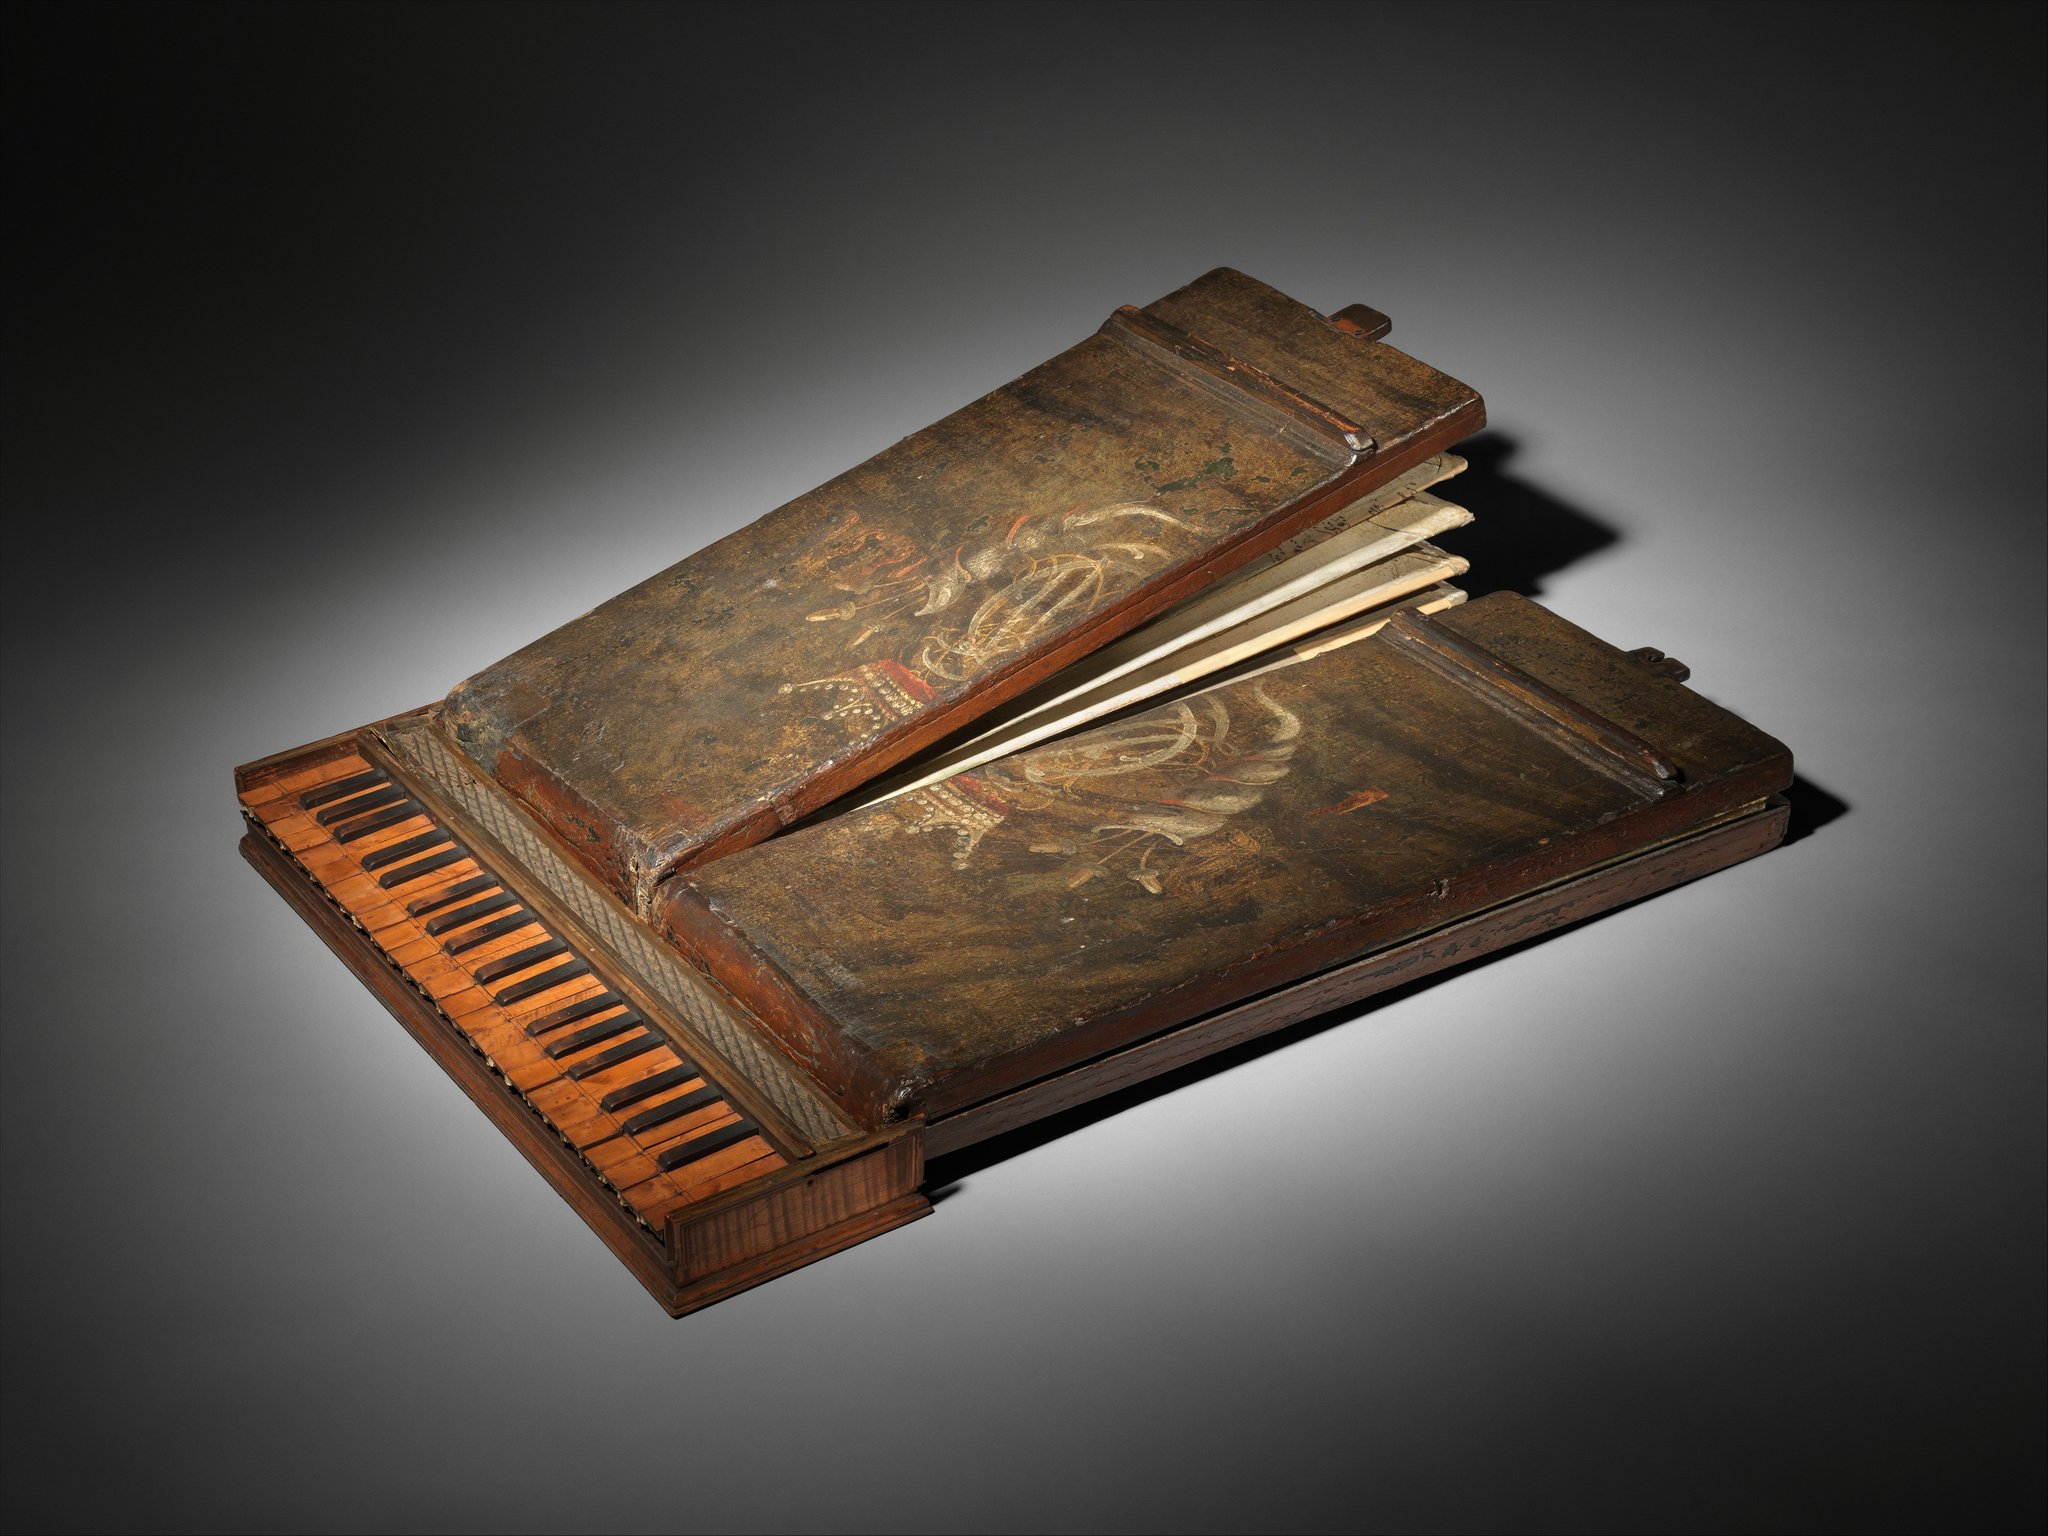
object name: regal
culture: german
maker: georg voll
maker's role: maker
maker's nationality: german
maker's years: 1540-1575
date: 1575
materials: wood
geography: germany